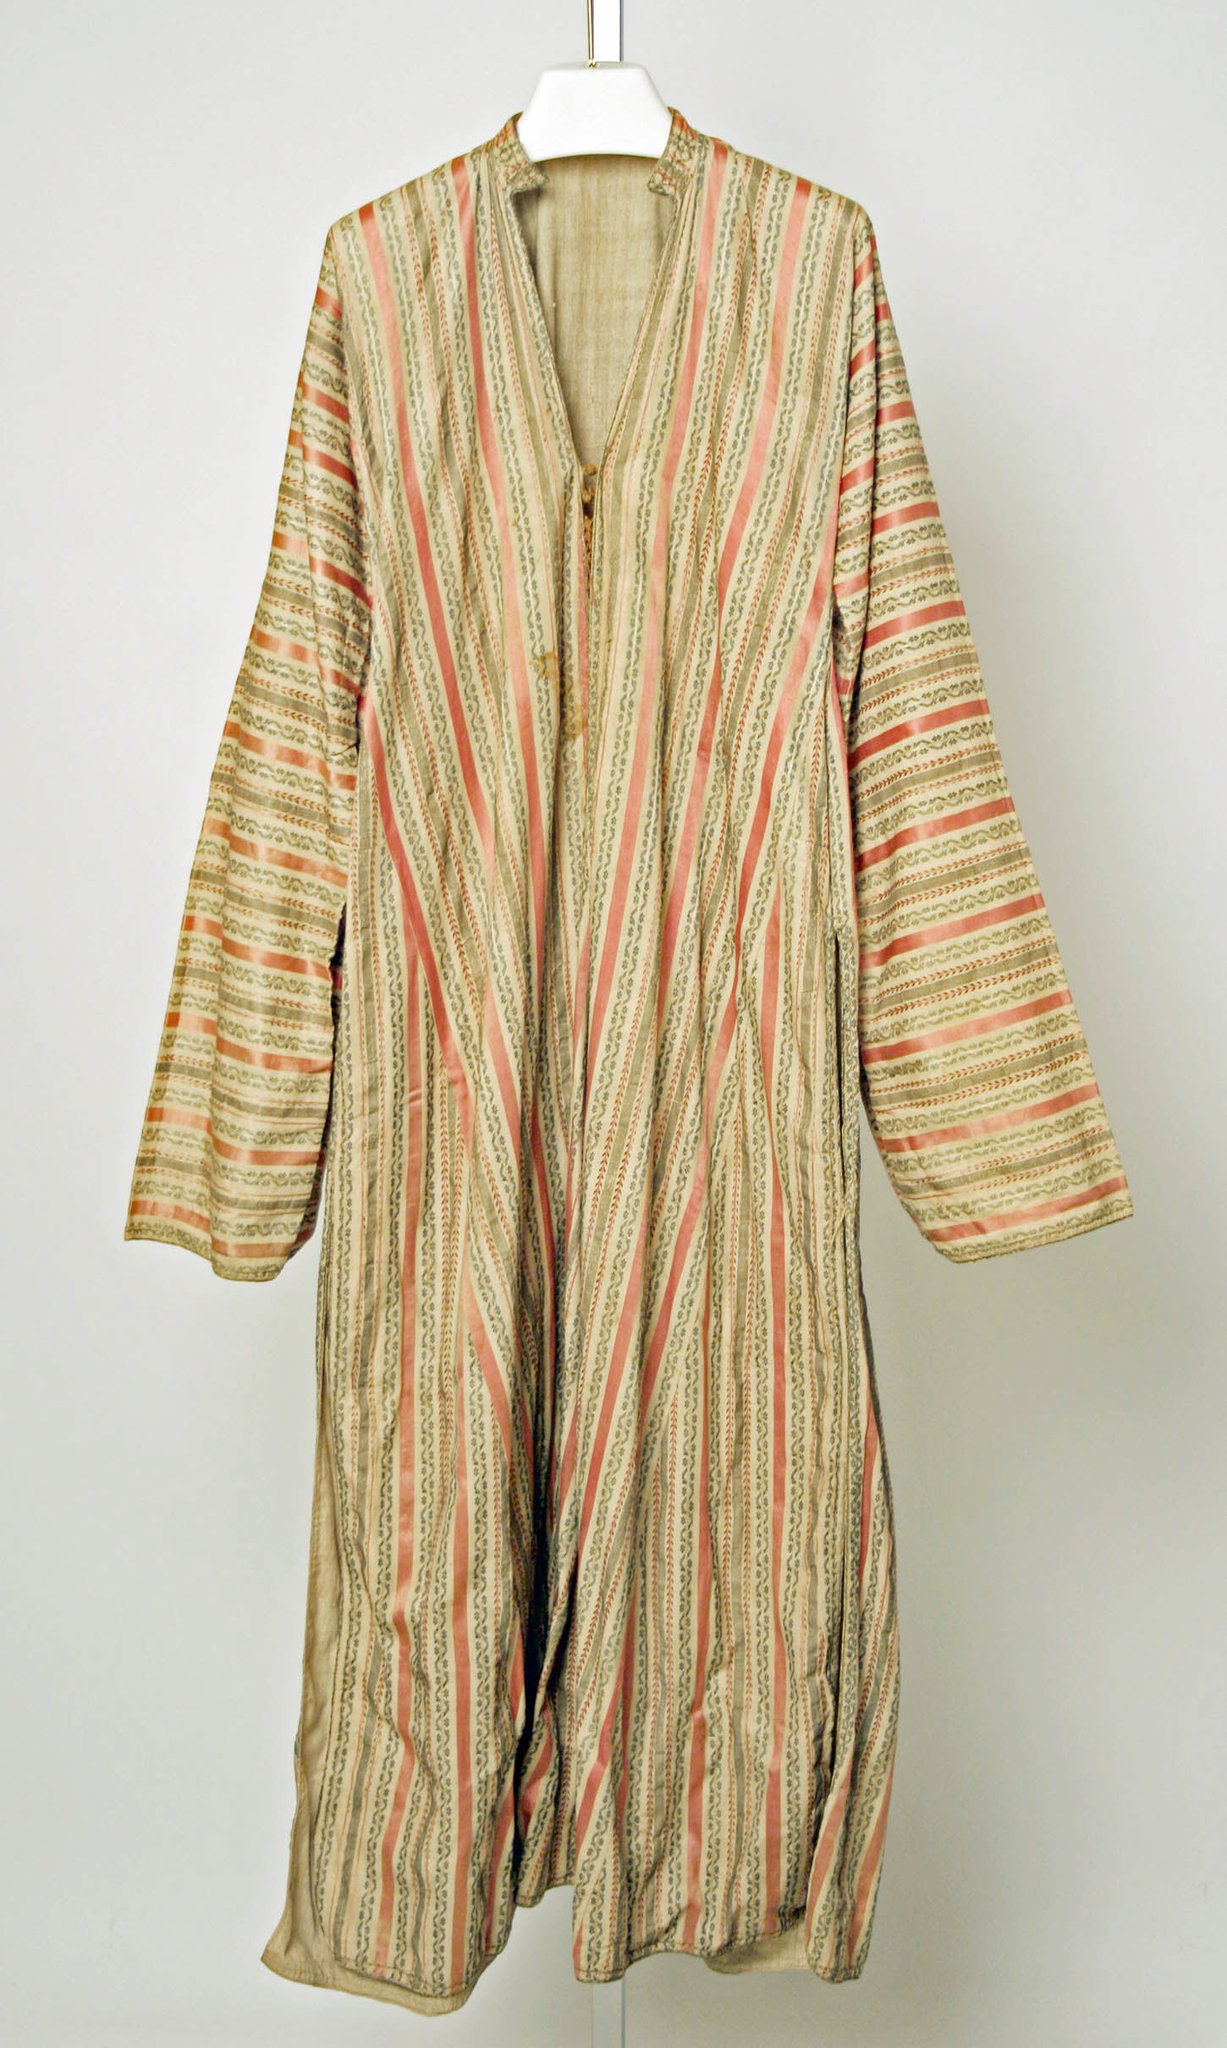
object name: robe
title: Uçetek Entari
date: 1801-1900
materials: cotton, metal thread, silk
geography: turkey